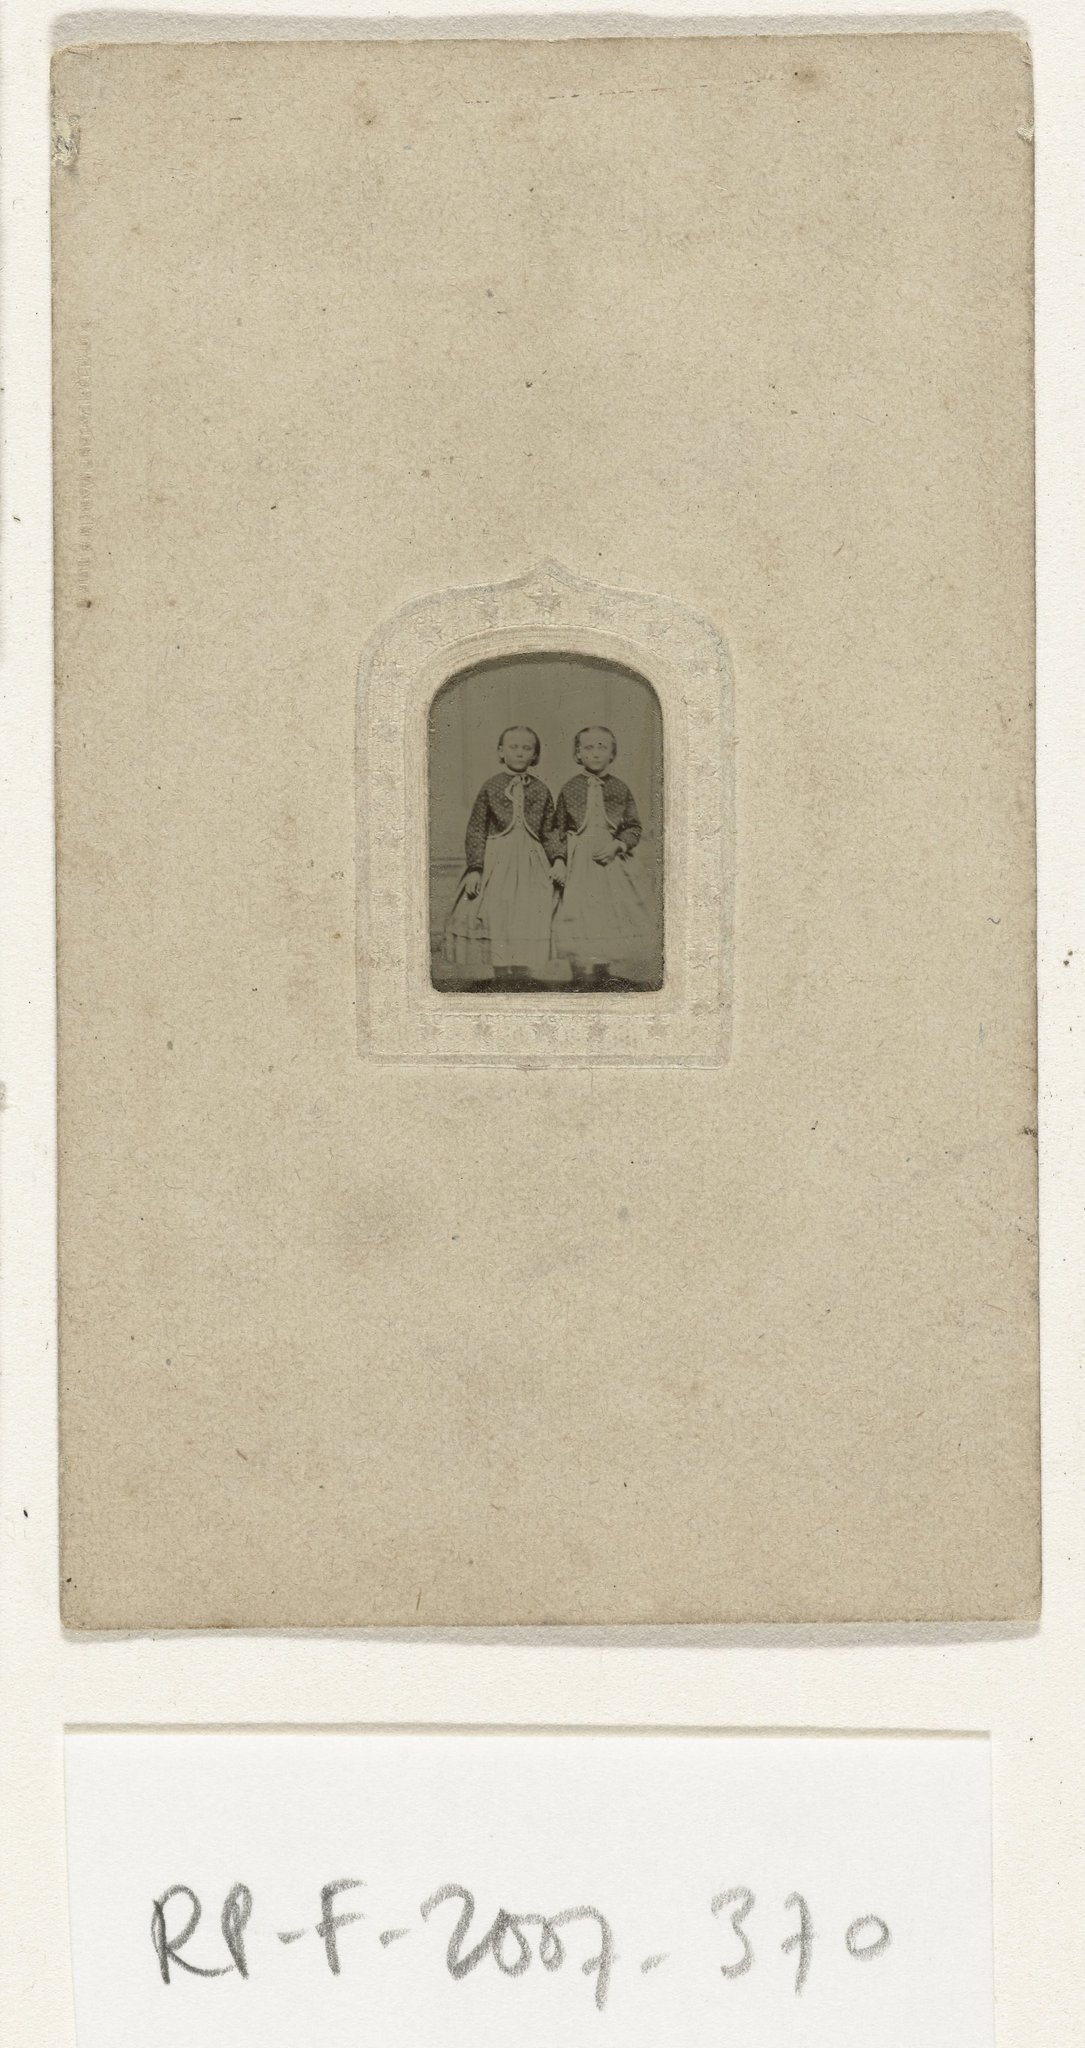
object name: photograph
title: Portret van twee meisjes (tweeling?)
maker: Anonymous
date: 1880-1910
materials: metal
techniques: ferrotyping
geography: united states